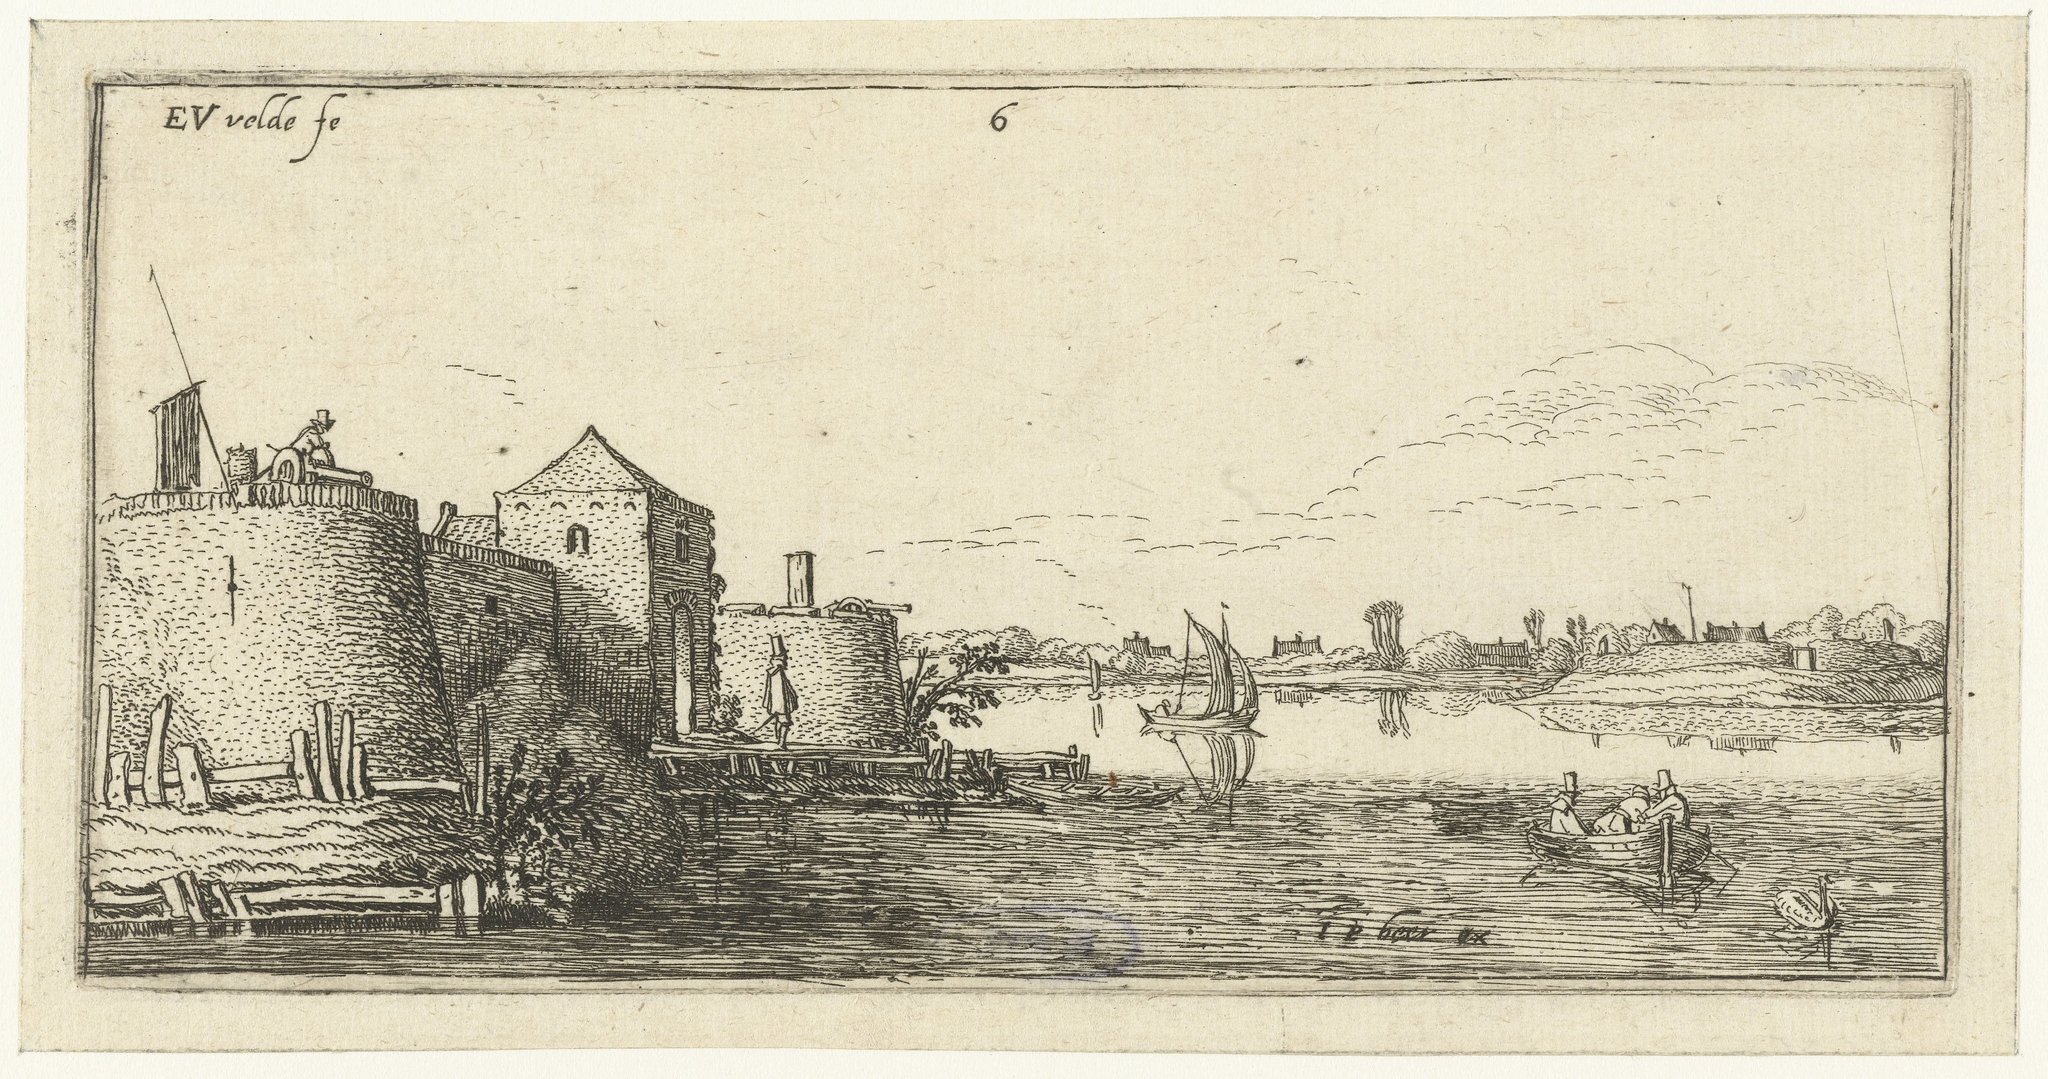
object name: print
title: Landschappen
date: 1615-1616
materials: paper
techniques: engraving, etching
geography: haarlem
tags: fortifications, military engineering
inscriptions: collector's mark: Lugt 2228a